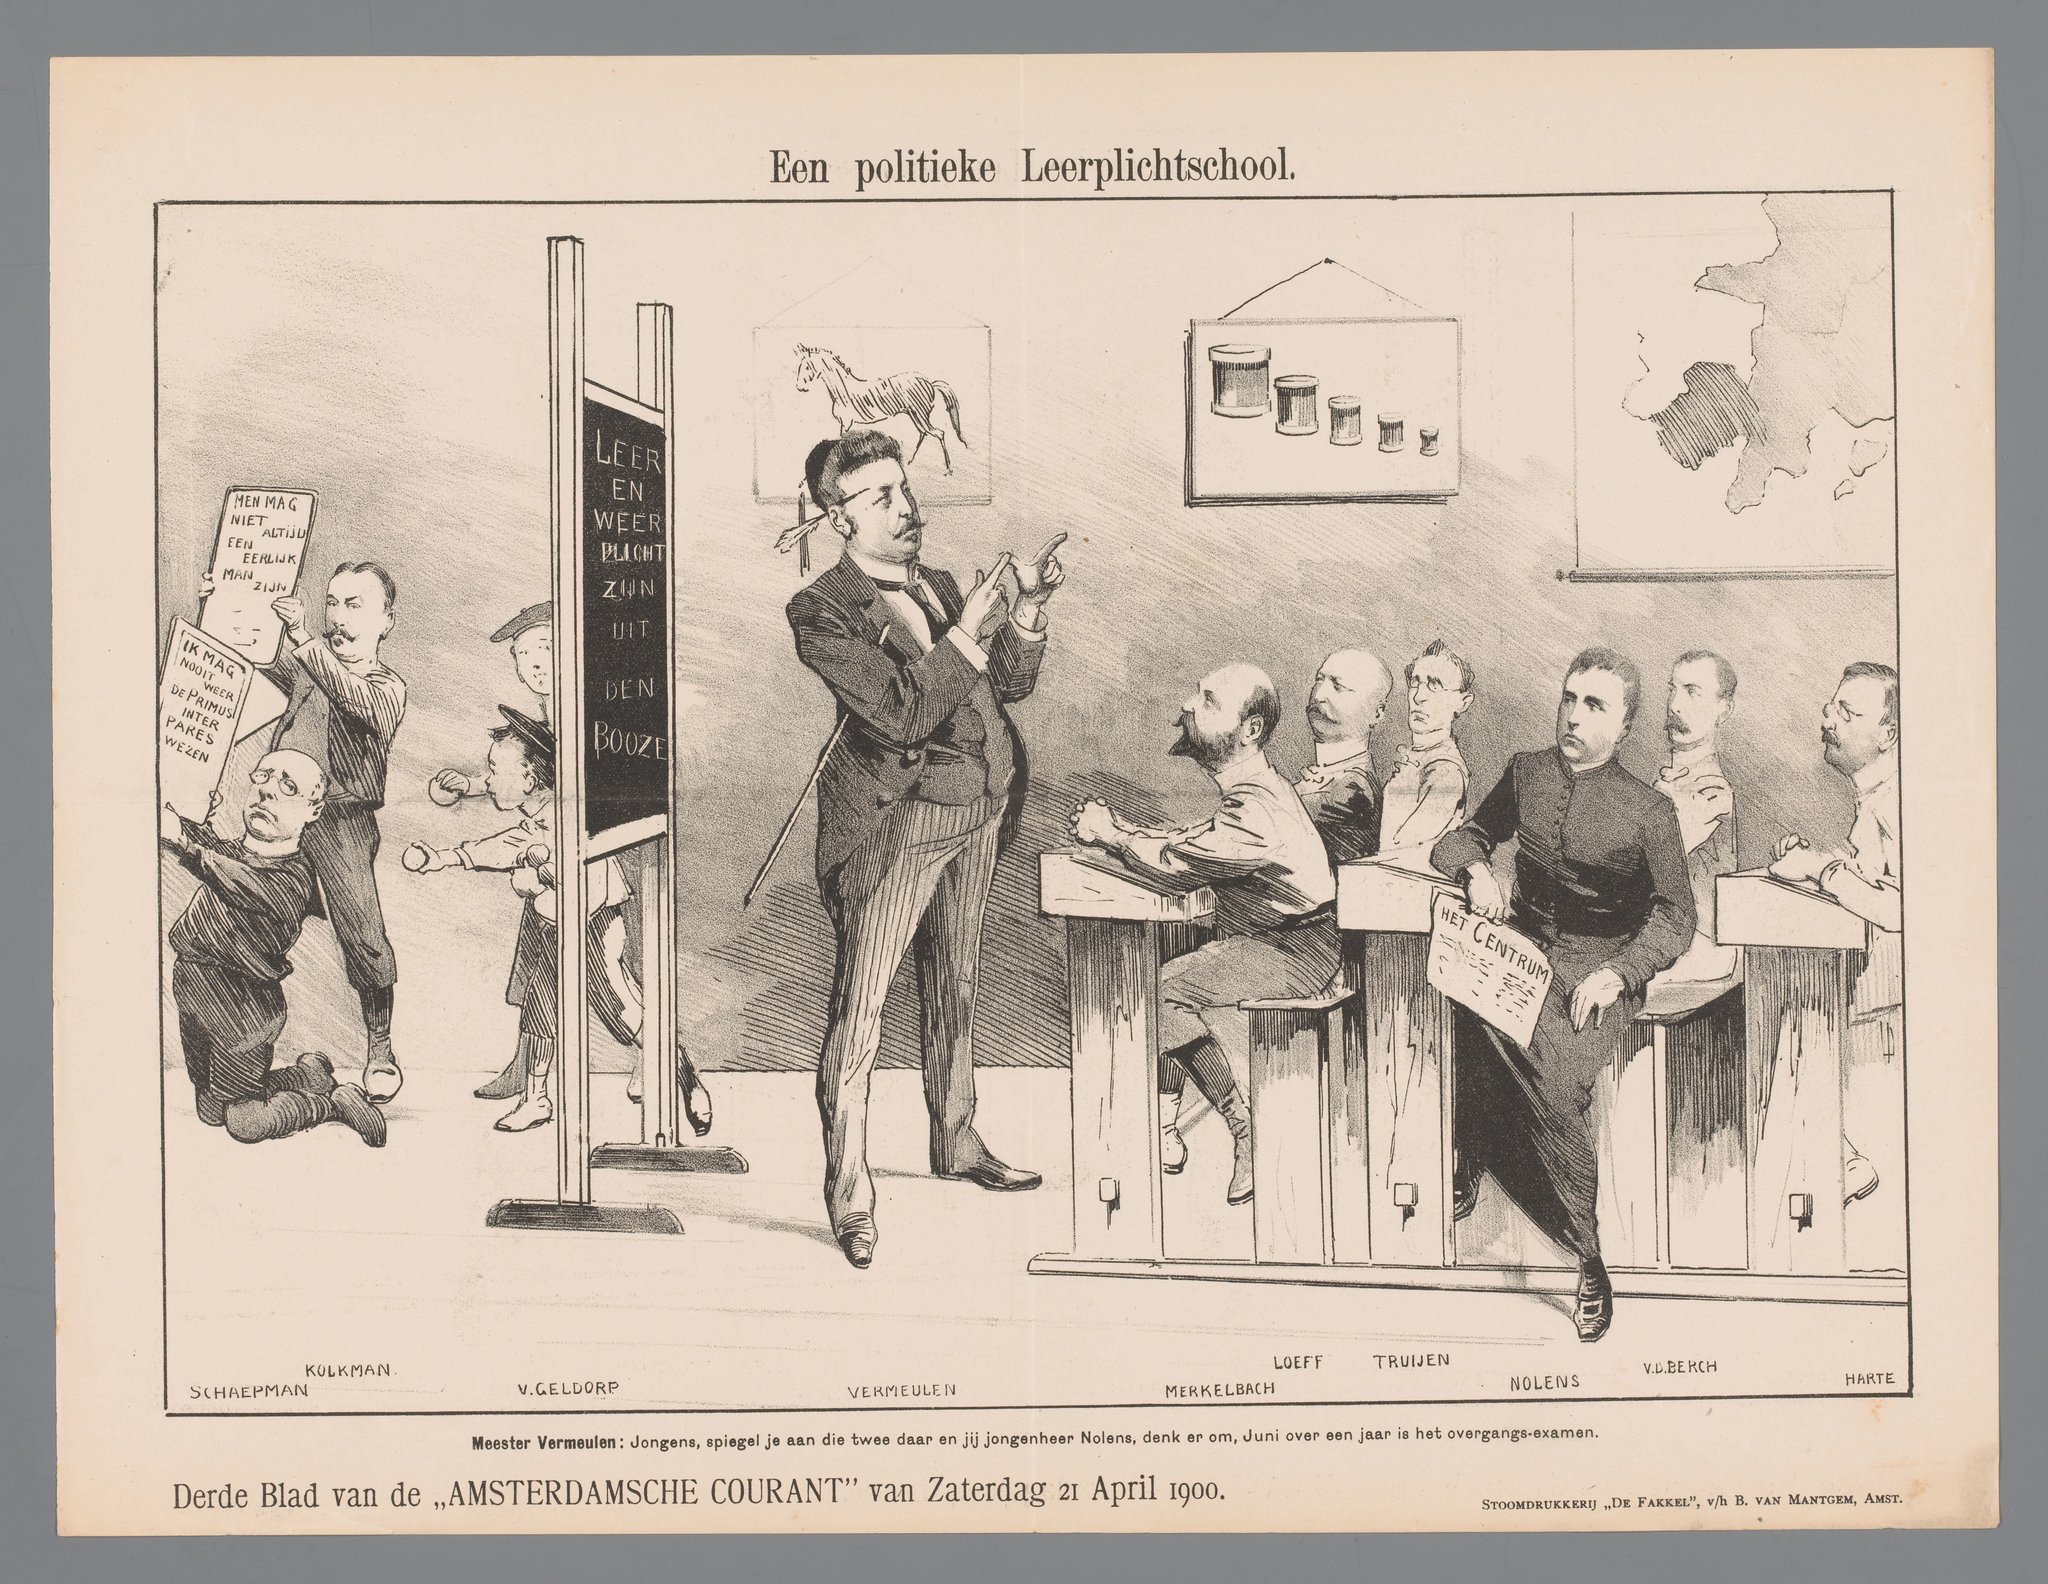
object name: cartoon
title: Een politieke Leerplichtschool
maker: petrus van geldorp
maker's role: draughtsman, print maker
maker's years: 1872-1939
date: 1900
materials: paper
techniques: lithograph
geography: amsterdam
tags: herman johannes aloysius maria schaepman, politician, the hague, priest, politician, e.g. party leader, elementary school; class, form, political caricatures and satires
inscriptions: date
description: Prent uit het bijvoegsel van: De Amsterdamsche Courant, 21 april 1900.